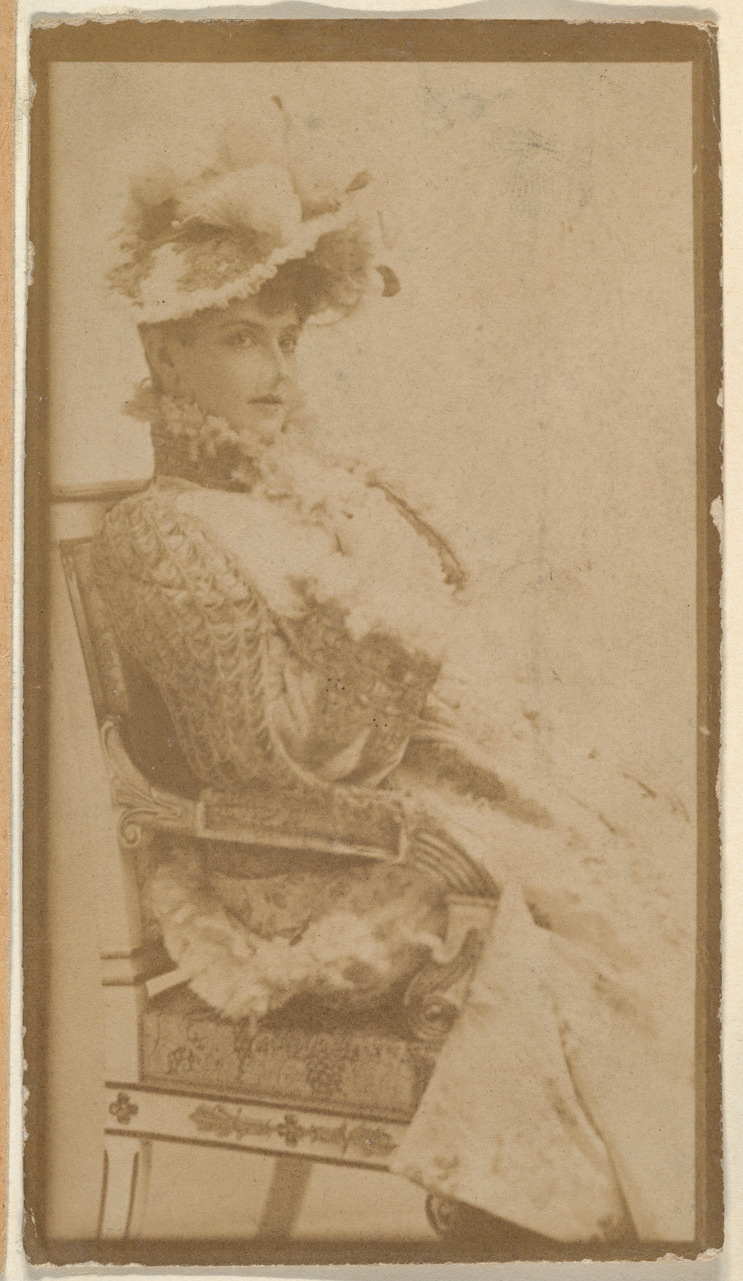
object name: photograph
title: Profile of seated actress, from the Actresses series (N668)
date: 1888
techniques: albumen silver print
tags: portraits,women,actresses